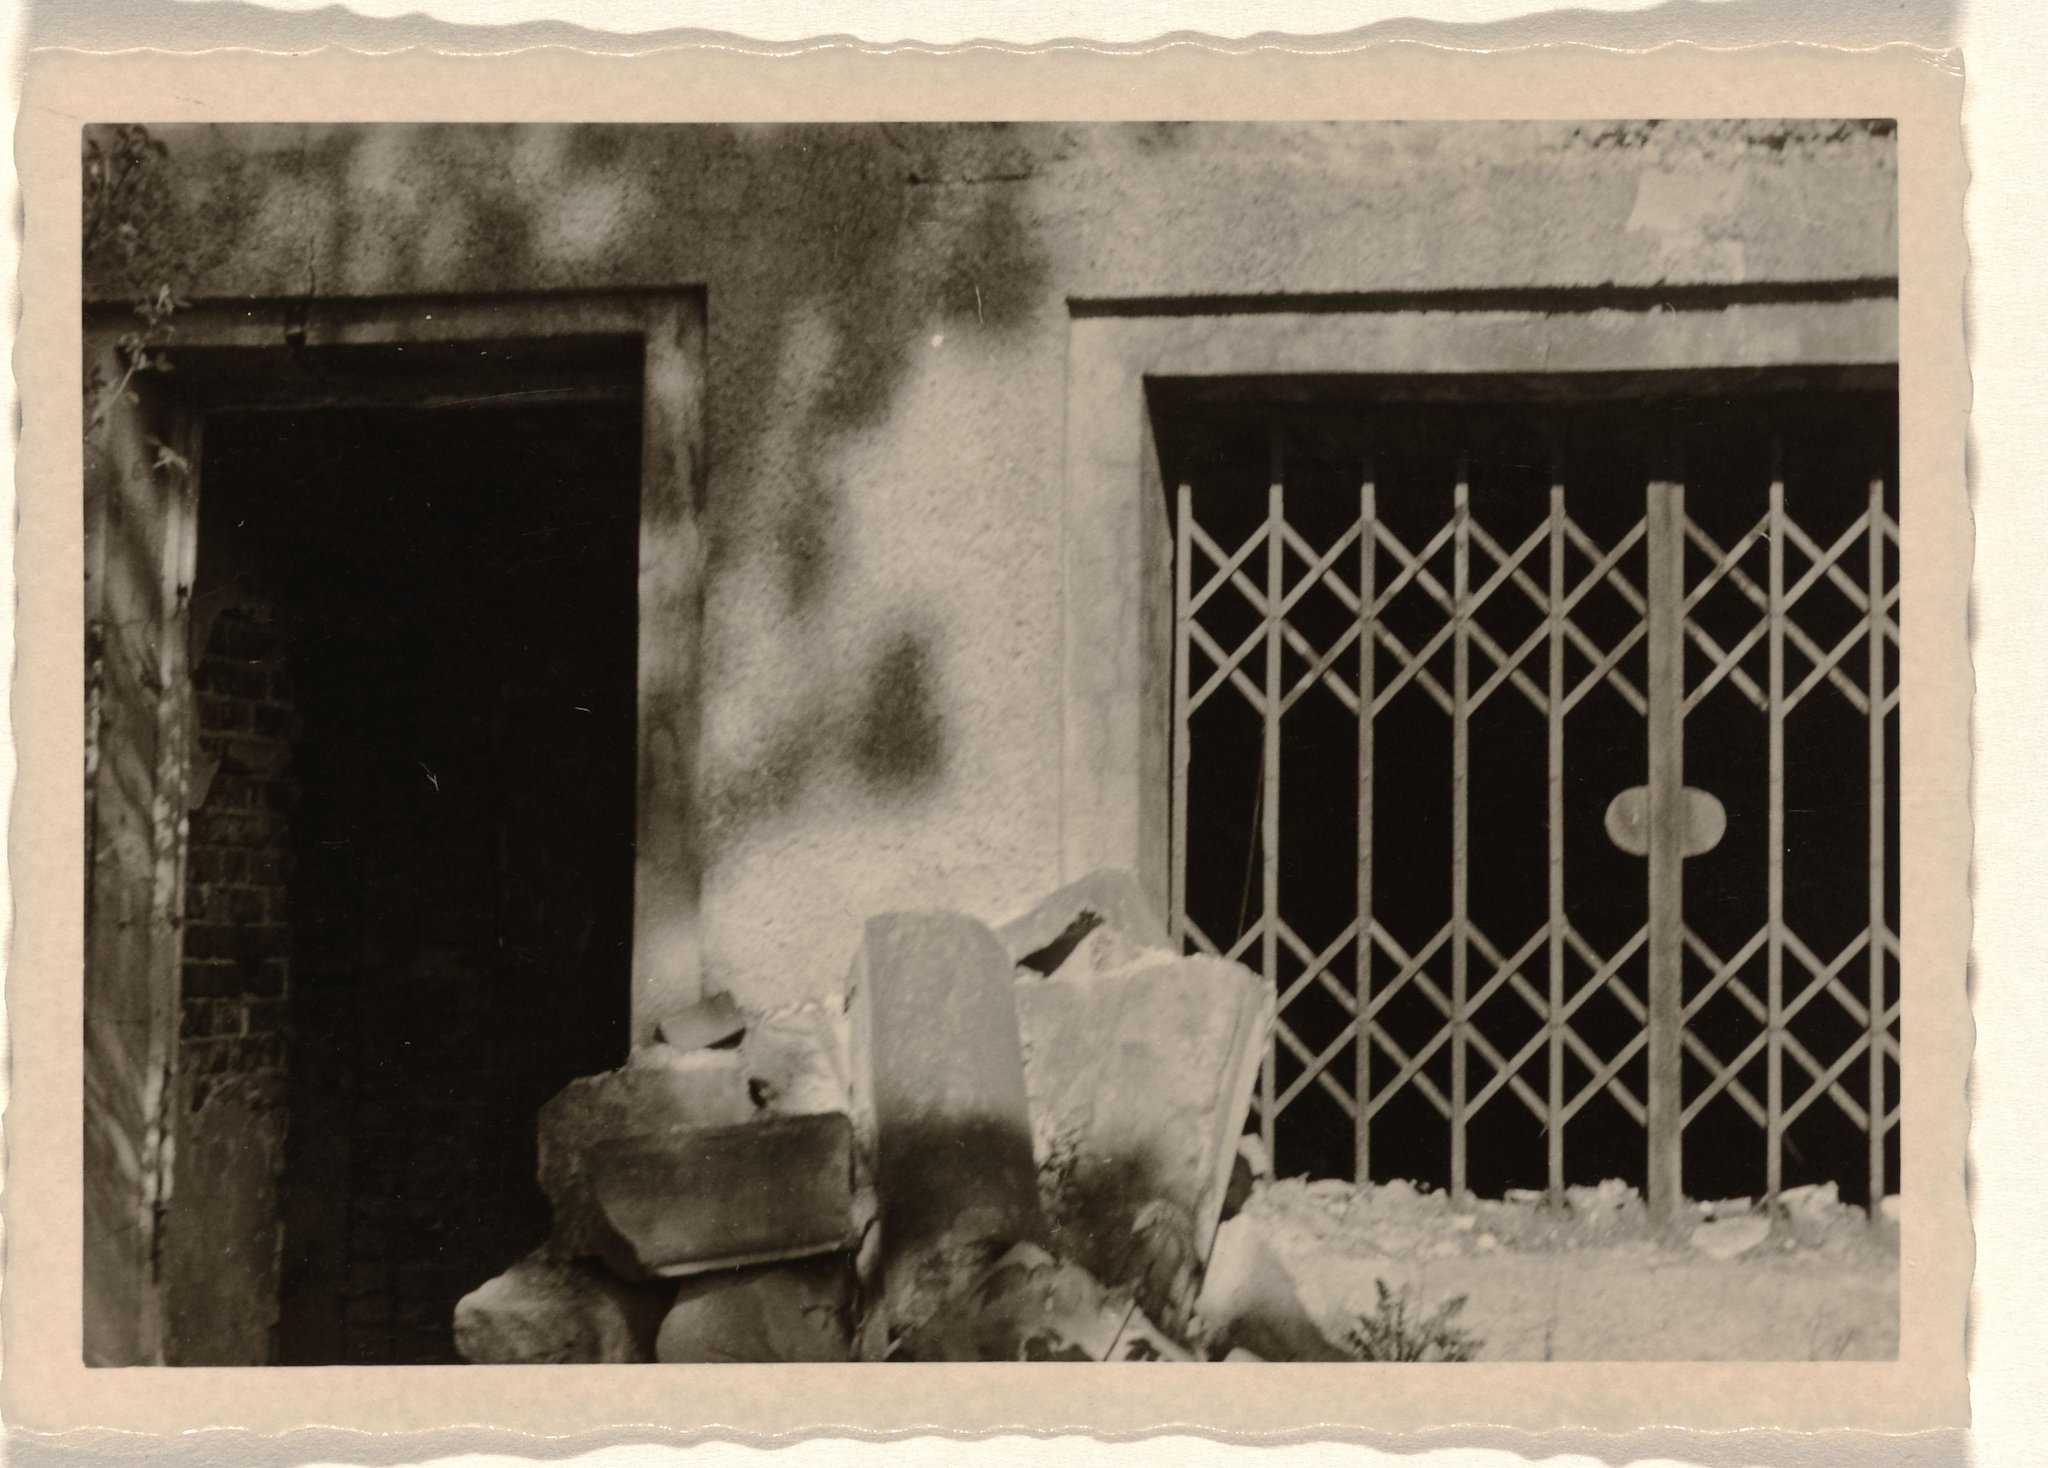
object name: photograph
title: Uitvergroting van een deel van een ruïne, met een schuifhek rechts en een deuropening links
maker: Anonymous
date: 1945-1970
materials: photographic support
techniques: gelatin silver print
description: Uitvergroting van een deel van een ruïne, met een schuifhek rechts en een deuropening links.